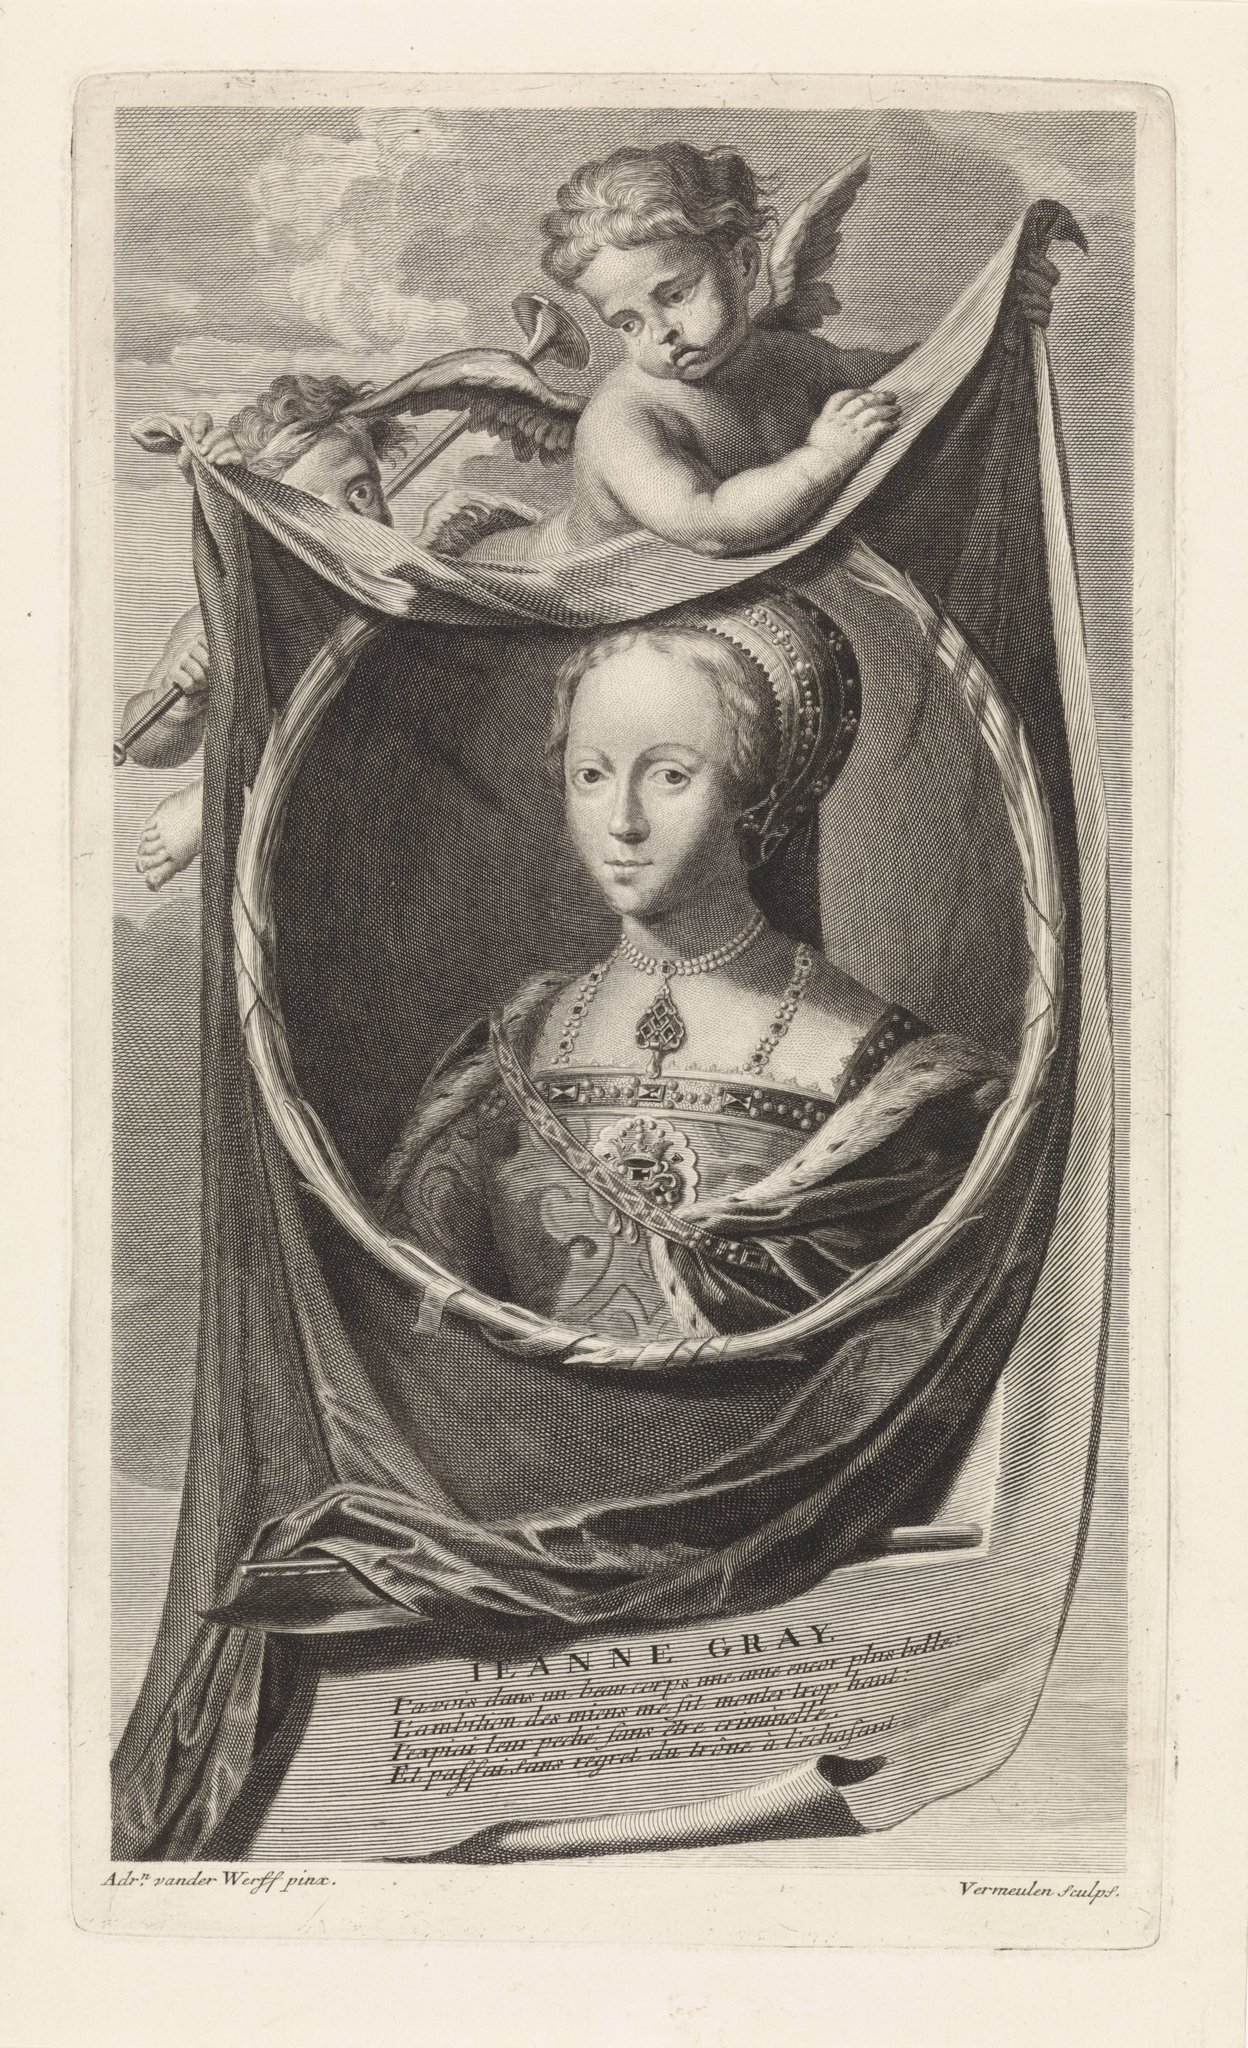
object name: print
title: Elf portretten uit de Engelse geschiedenis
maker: adriaen van der werff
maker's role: draughtsman, painter, print maker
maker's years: 1659-1722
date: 1697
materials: paper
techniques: engraving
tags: london, cupids: 'amores', 'amoretti', 'putti'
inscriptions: collector's mark: Lugt 2228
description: Prent ook gebruikt als boekillustratie in: Larrey, Isaac de. Histoire d'Angleterre, d'Ecosse, et d'Irlande. 4 dln. Rotterdam: Reinier Leers, 1697-1713.